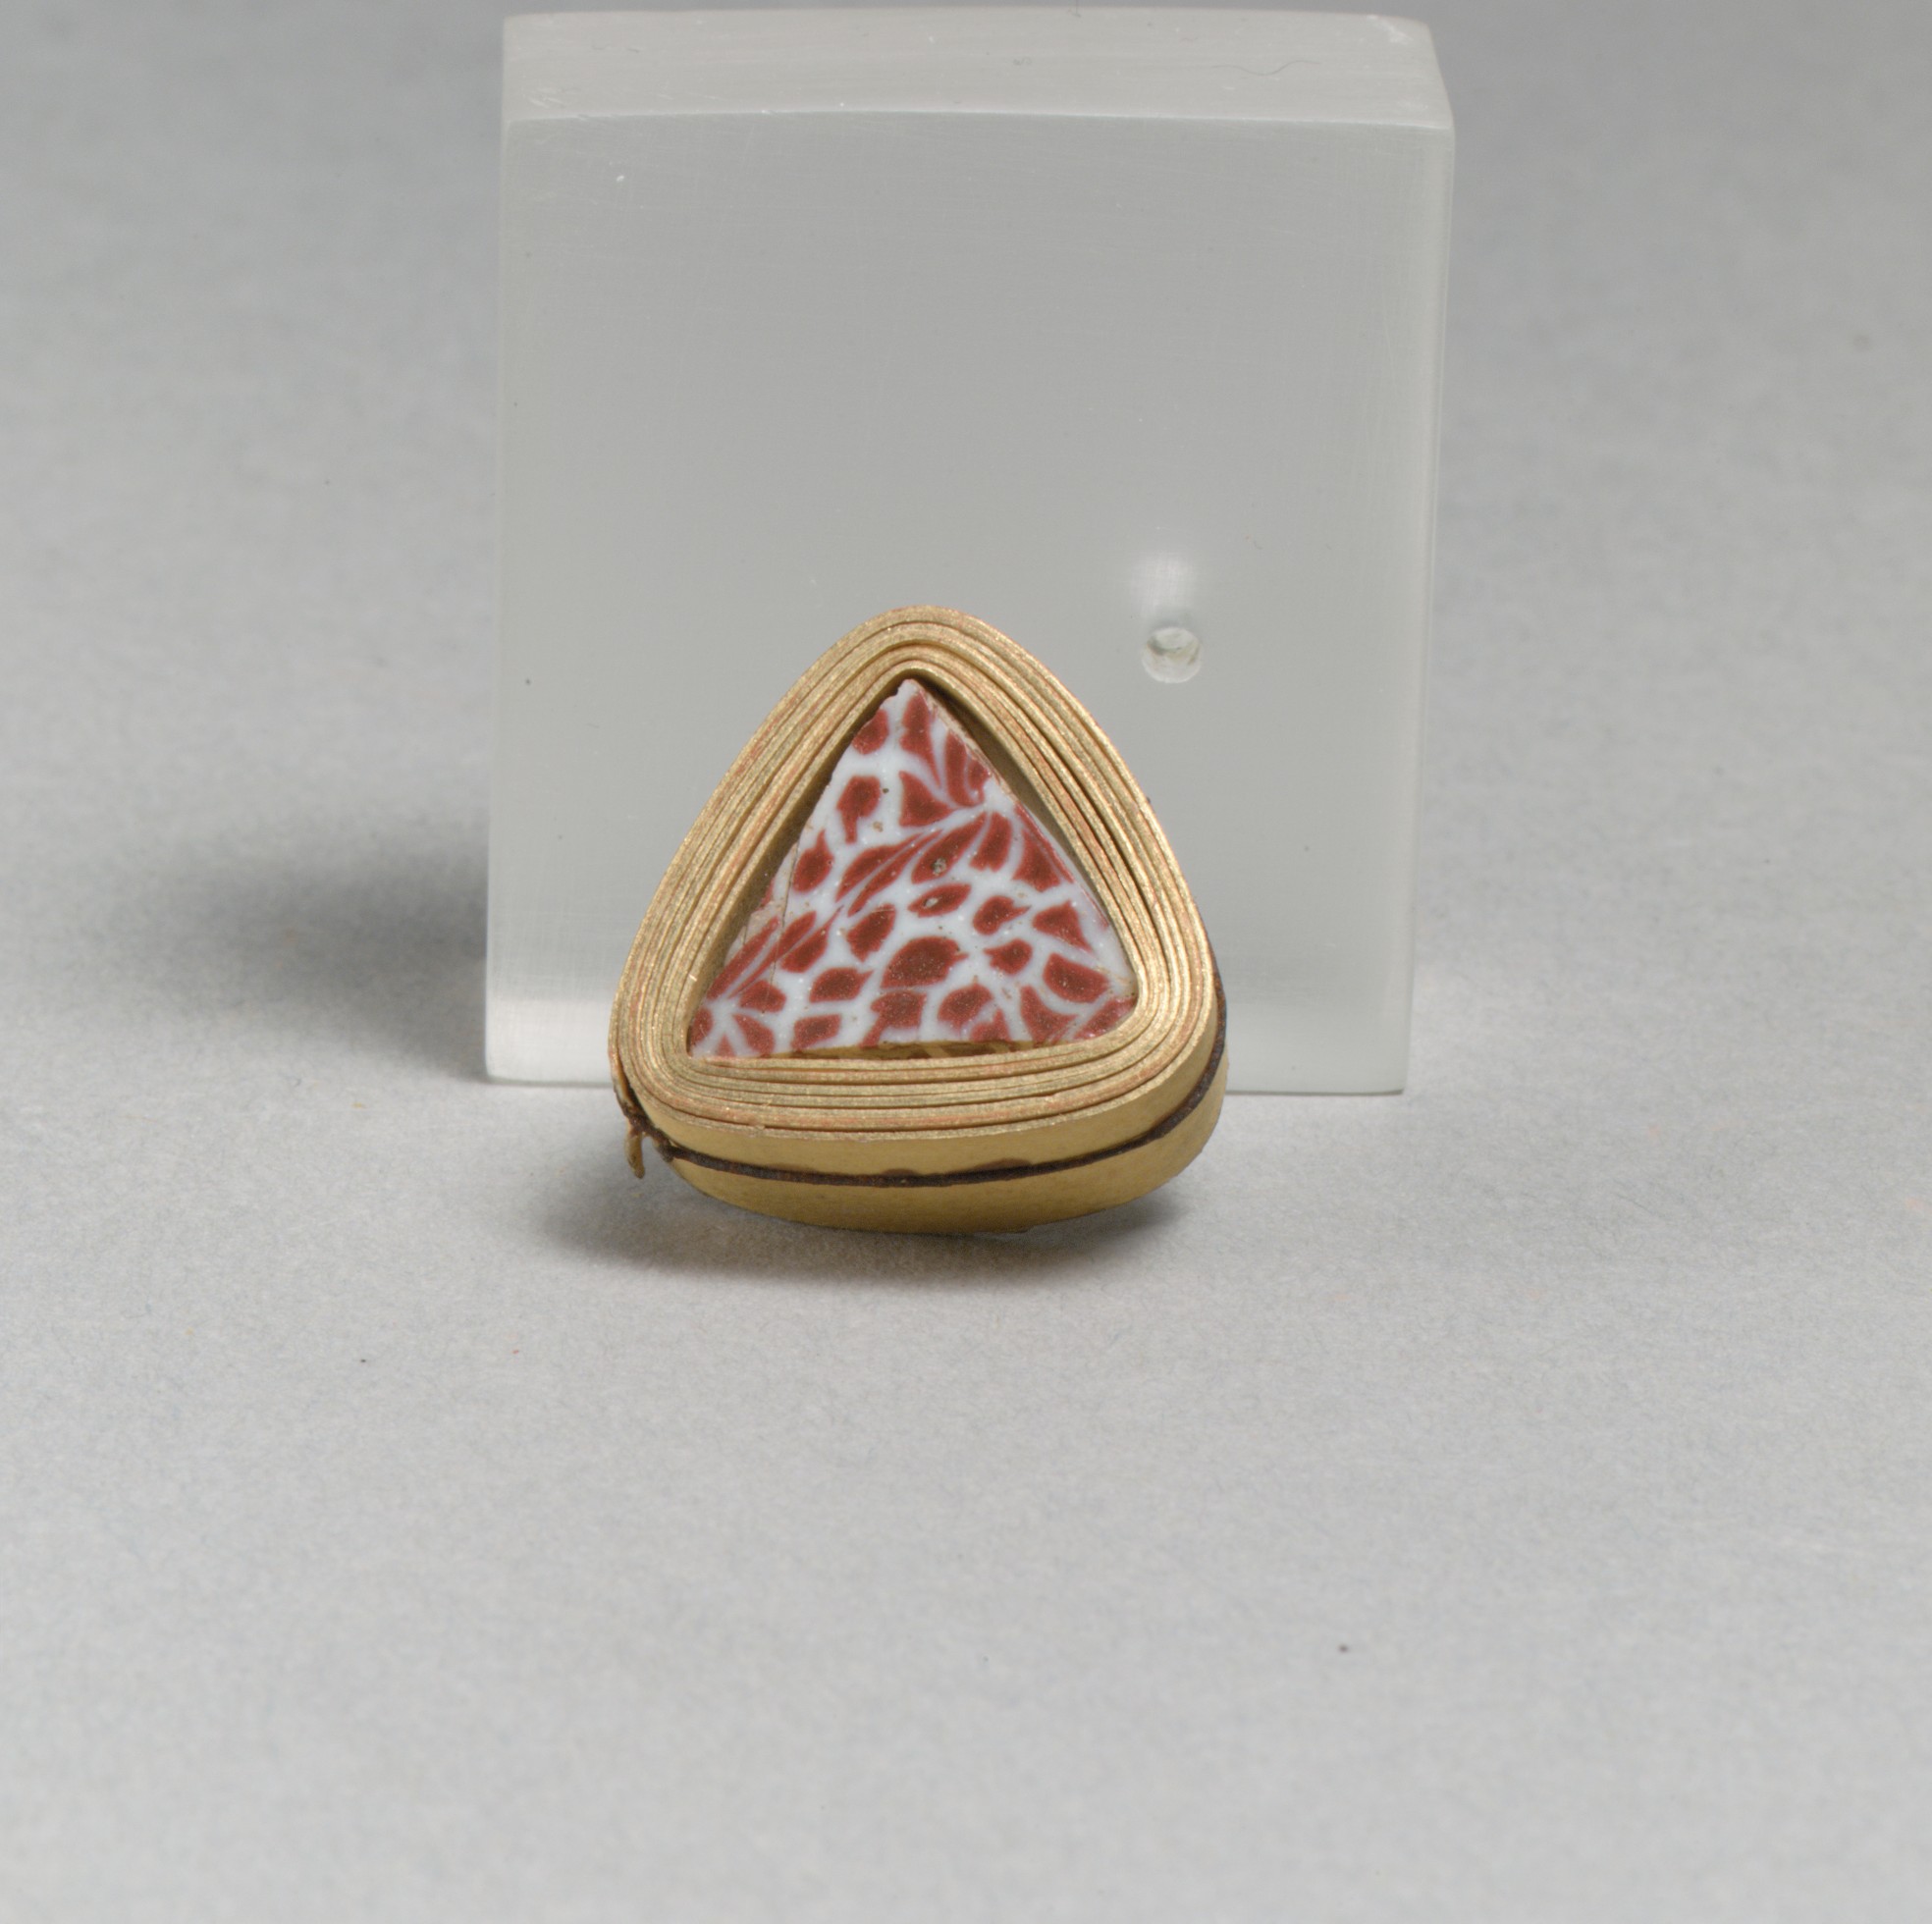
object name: fragment, mosaic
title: Glass mosaic fragment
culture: roman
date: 34 BCE-33 CE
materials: glass